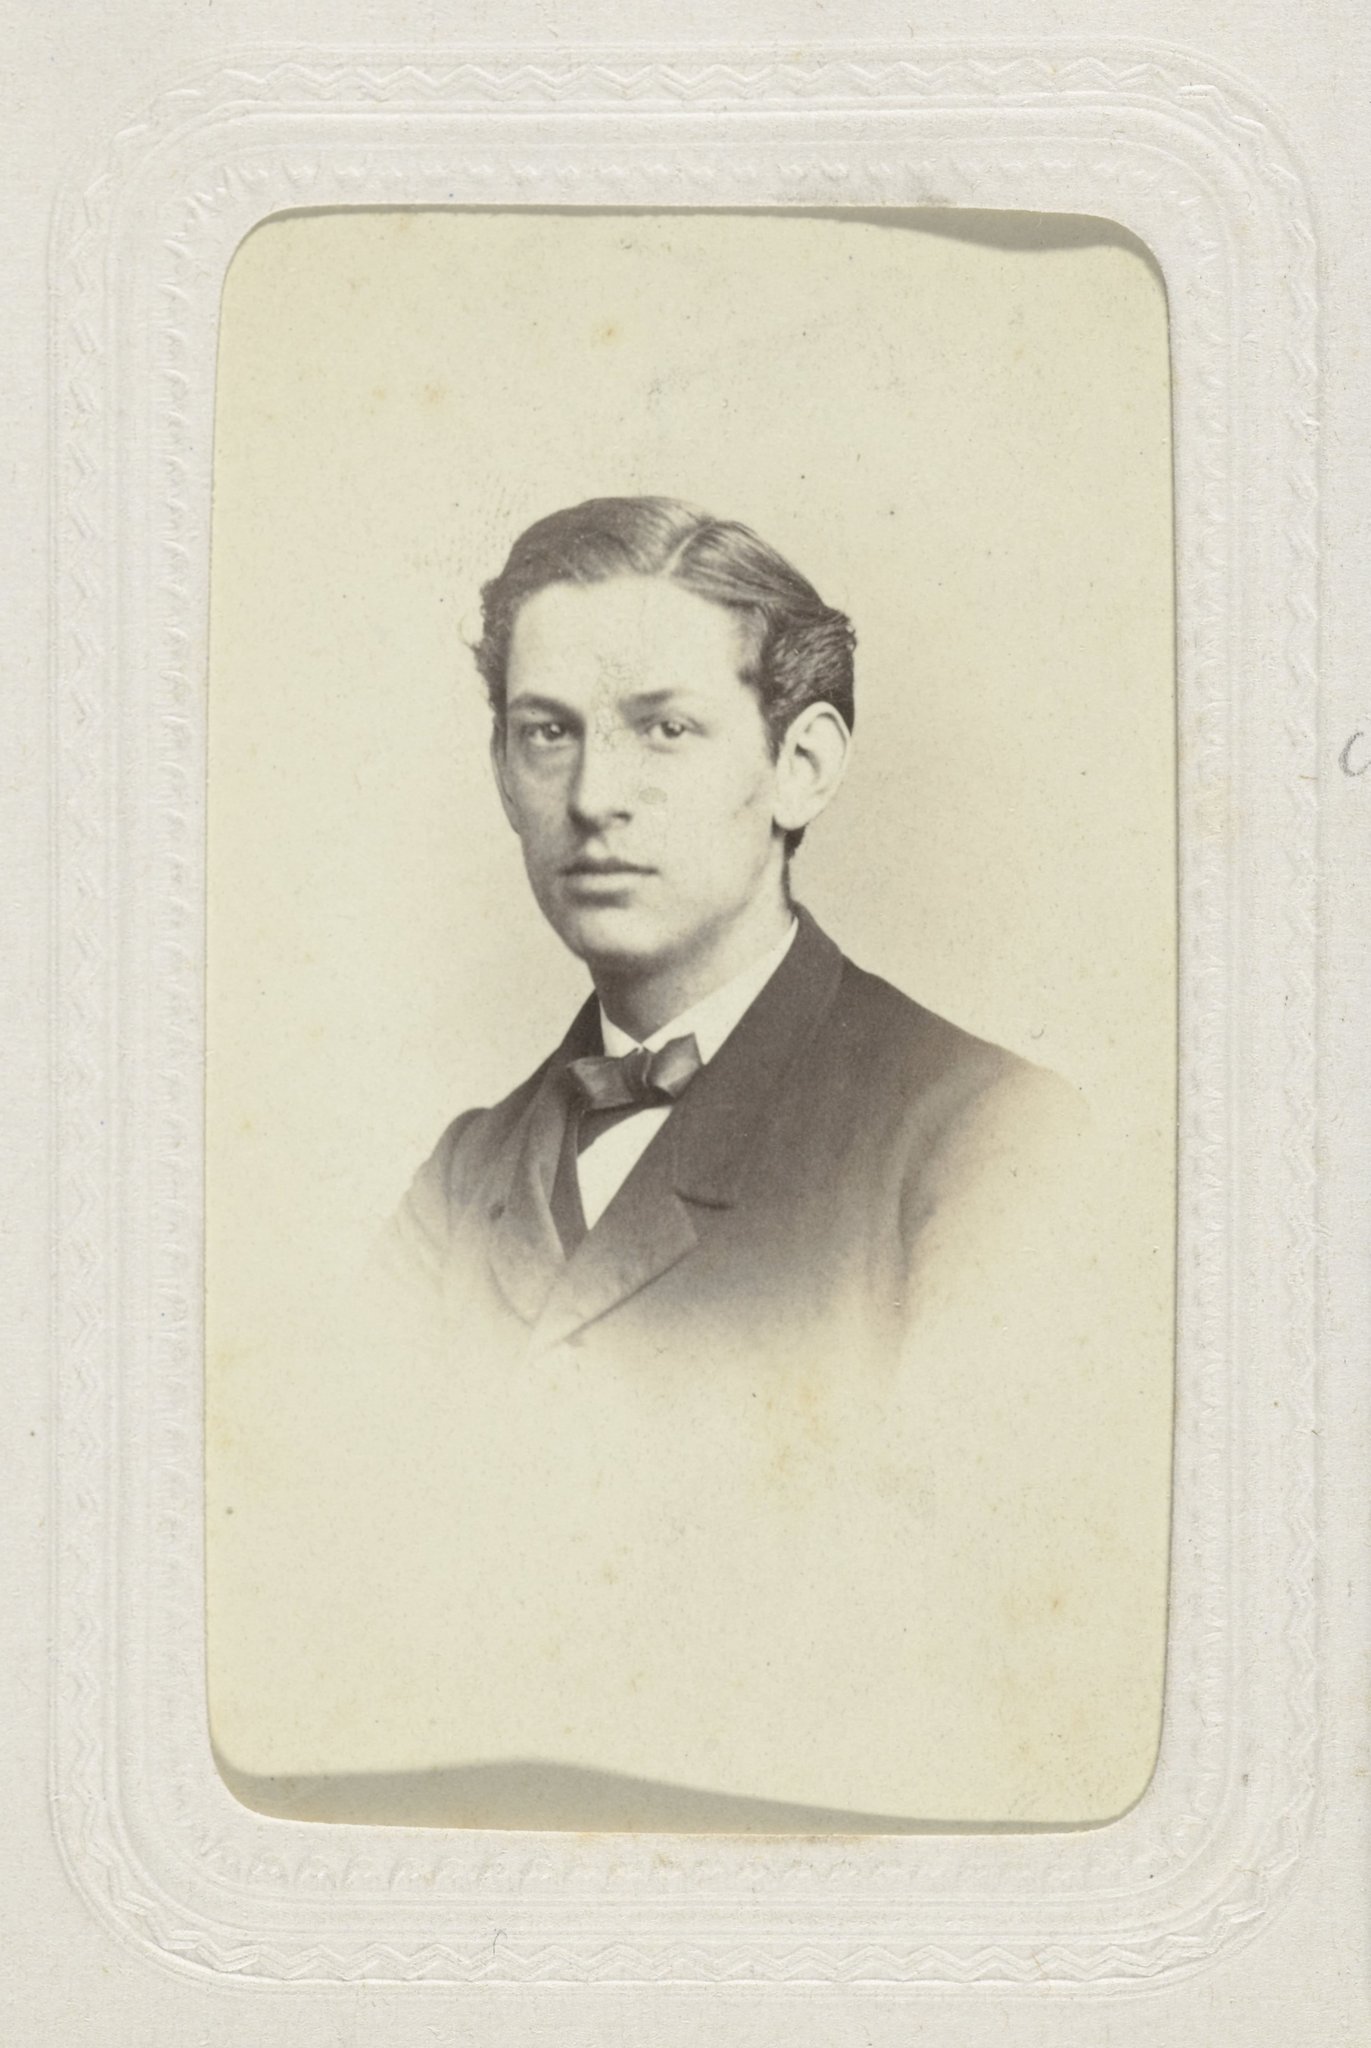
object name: carte de visite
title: Studioportret van een jongeman met een scheiding in zijn haar en een vlinderdas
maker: Anonymous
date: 1863-1870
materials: cardboard, paper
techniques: albumen print